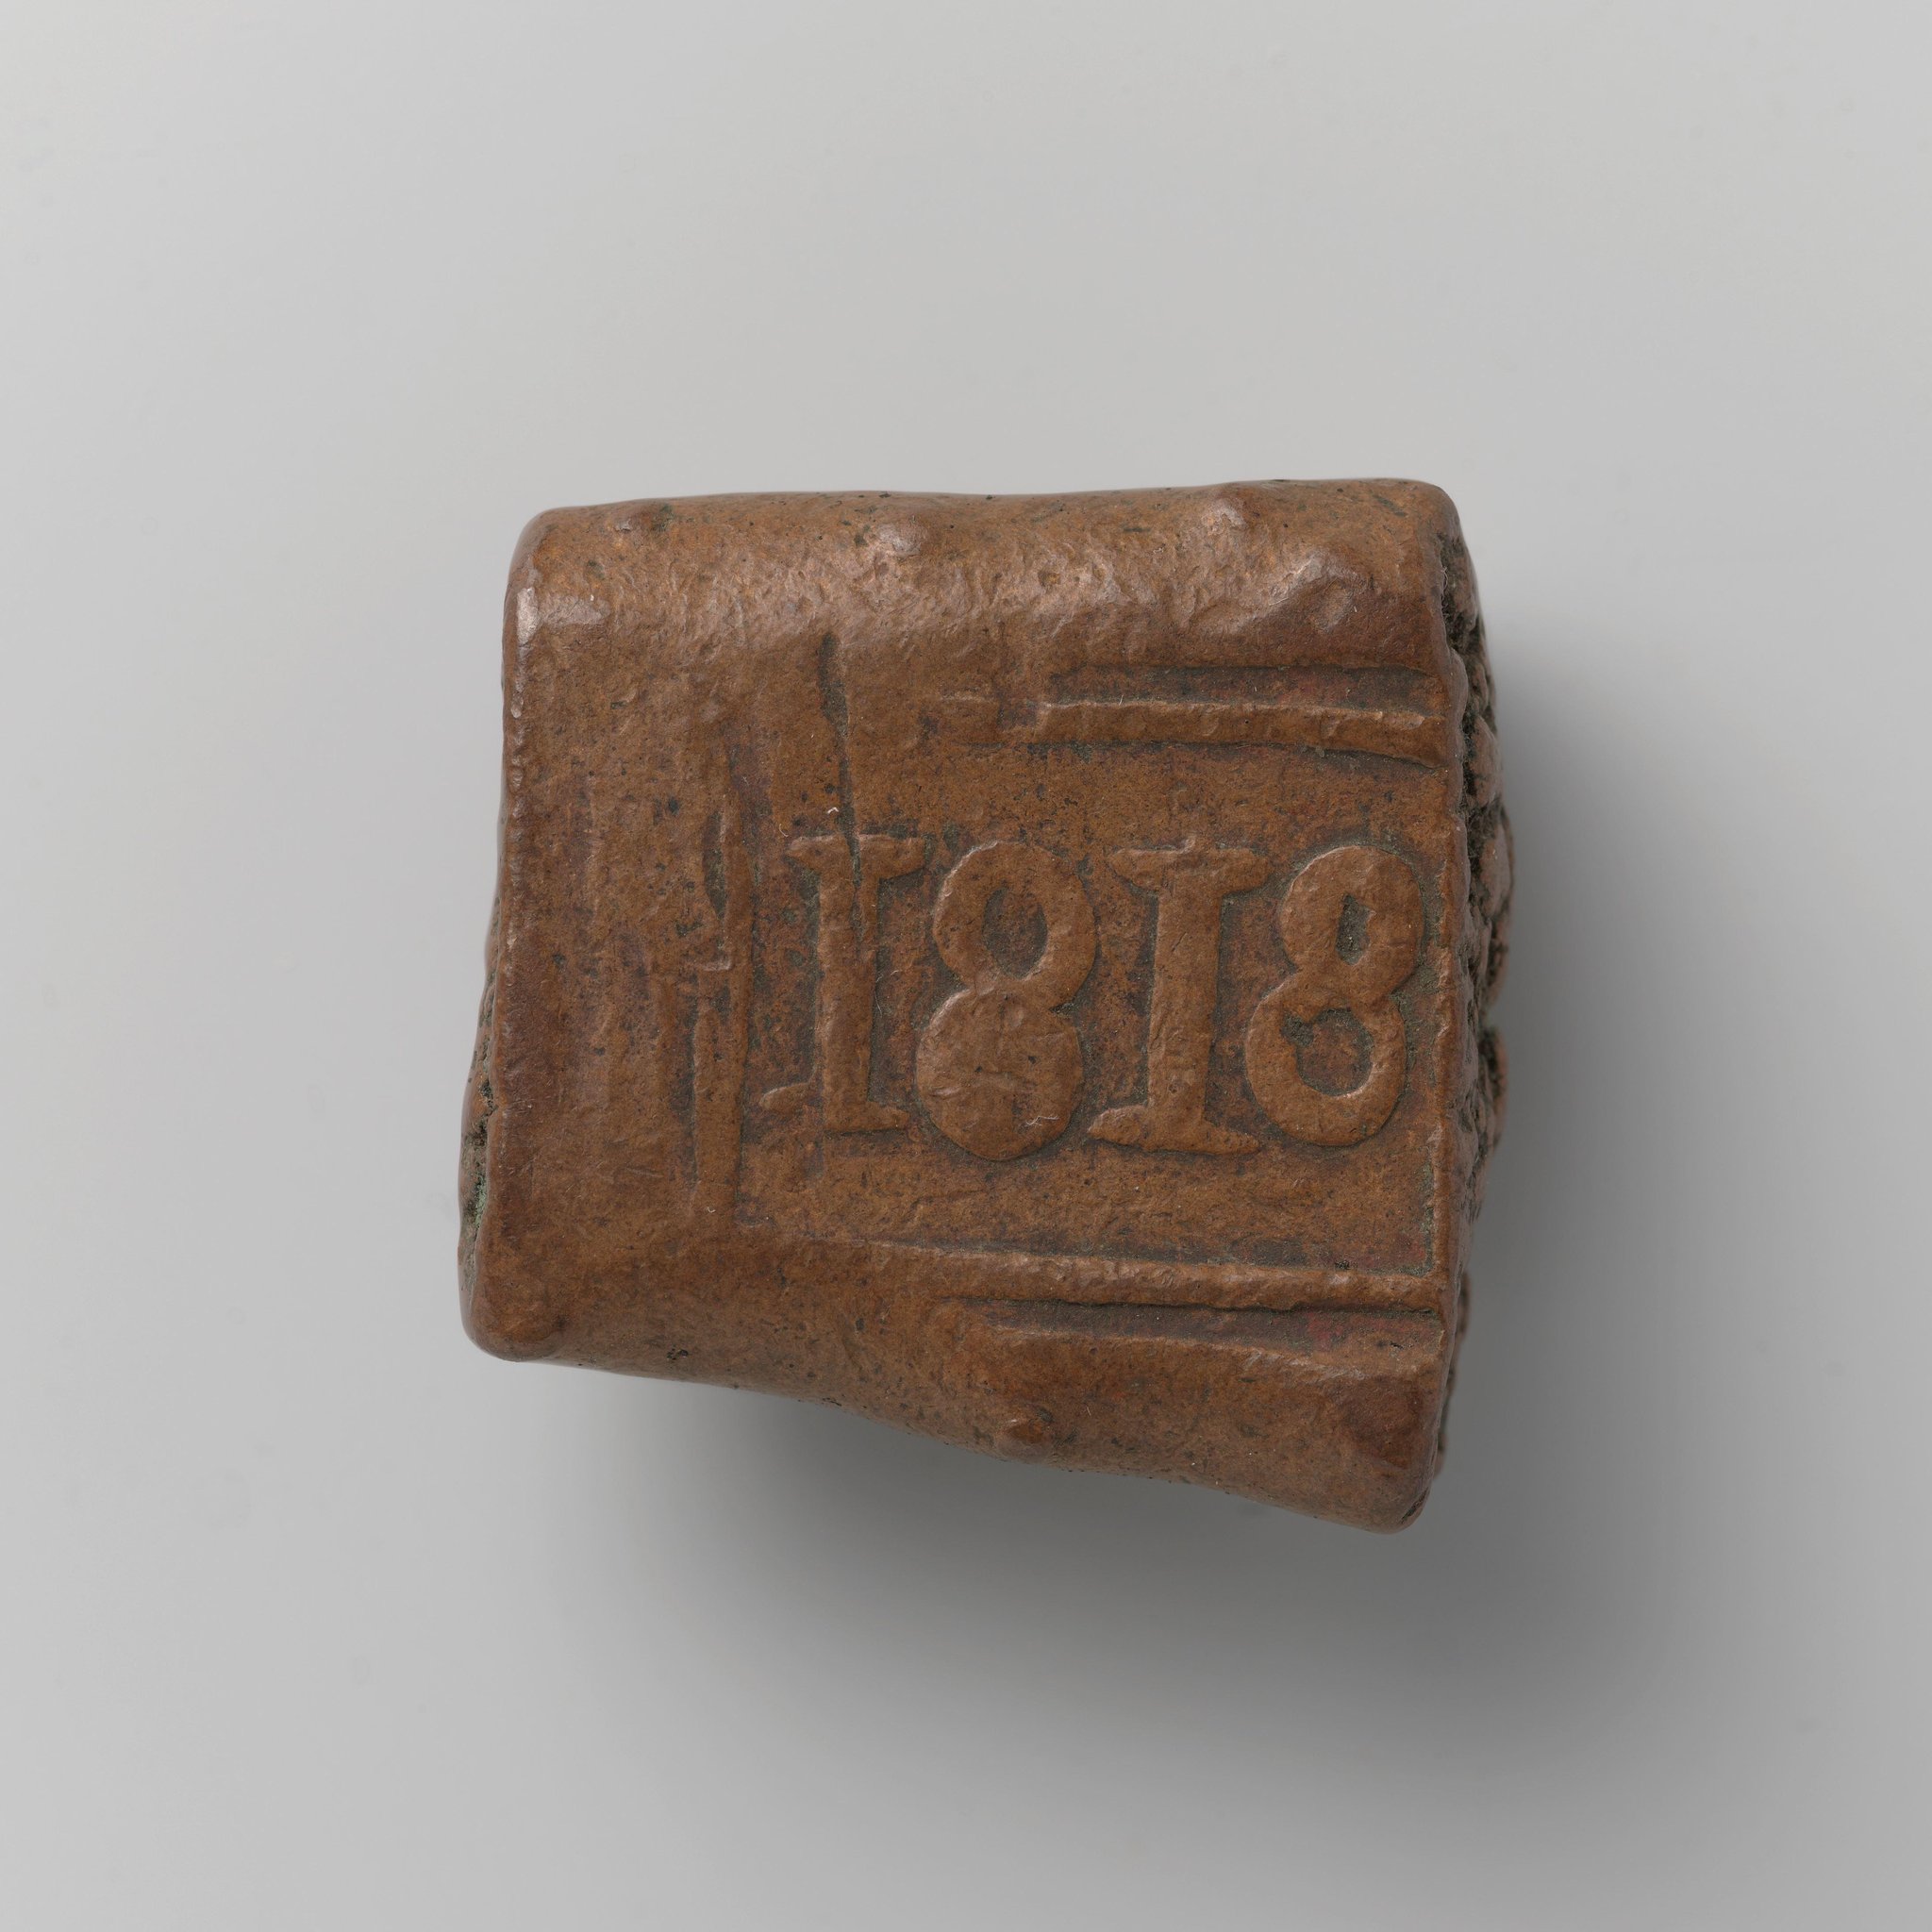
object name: coin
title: Nederlands Indië, 2 stuiver bonk,1818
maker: william i of the netherlands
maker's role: koning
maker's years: 1772-1843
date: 1818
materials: copper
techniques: striking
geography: surabaya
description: Koperen rechthoekige munt. Voorzijde: binnen een rechthoekige lijst waarde-aanduiding 2 St. Keerzijde: binnen een rechthoekige lijst jaartal.